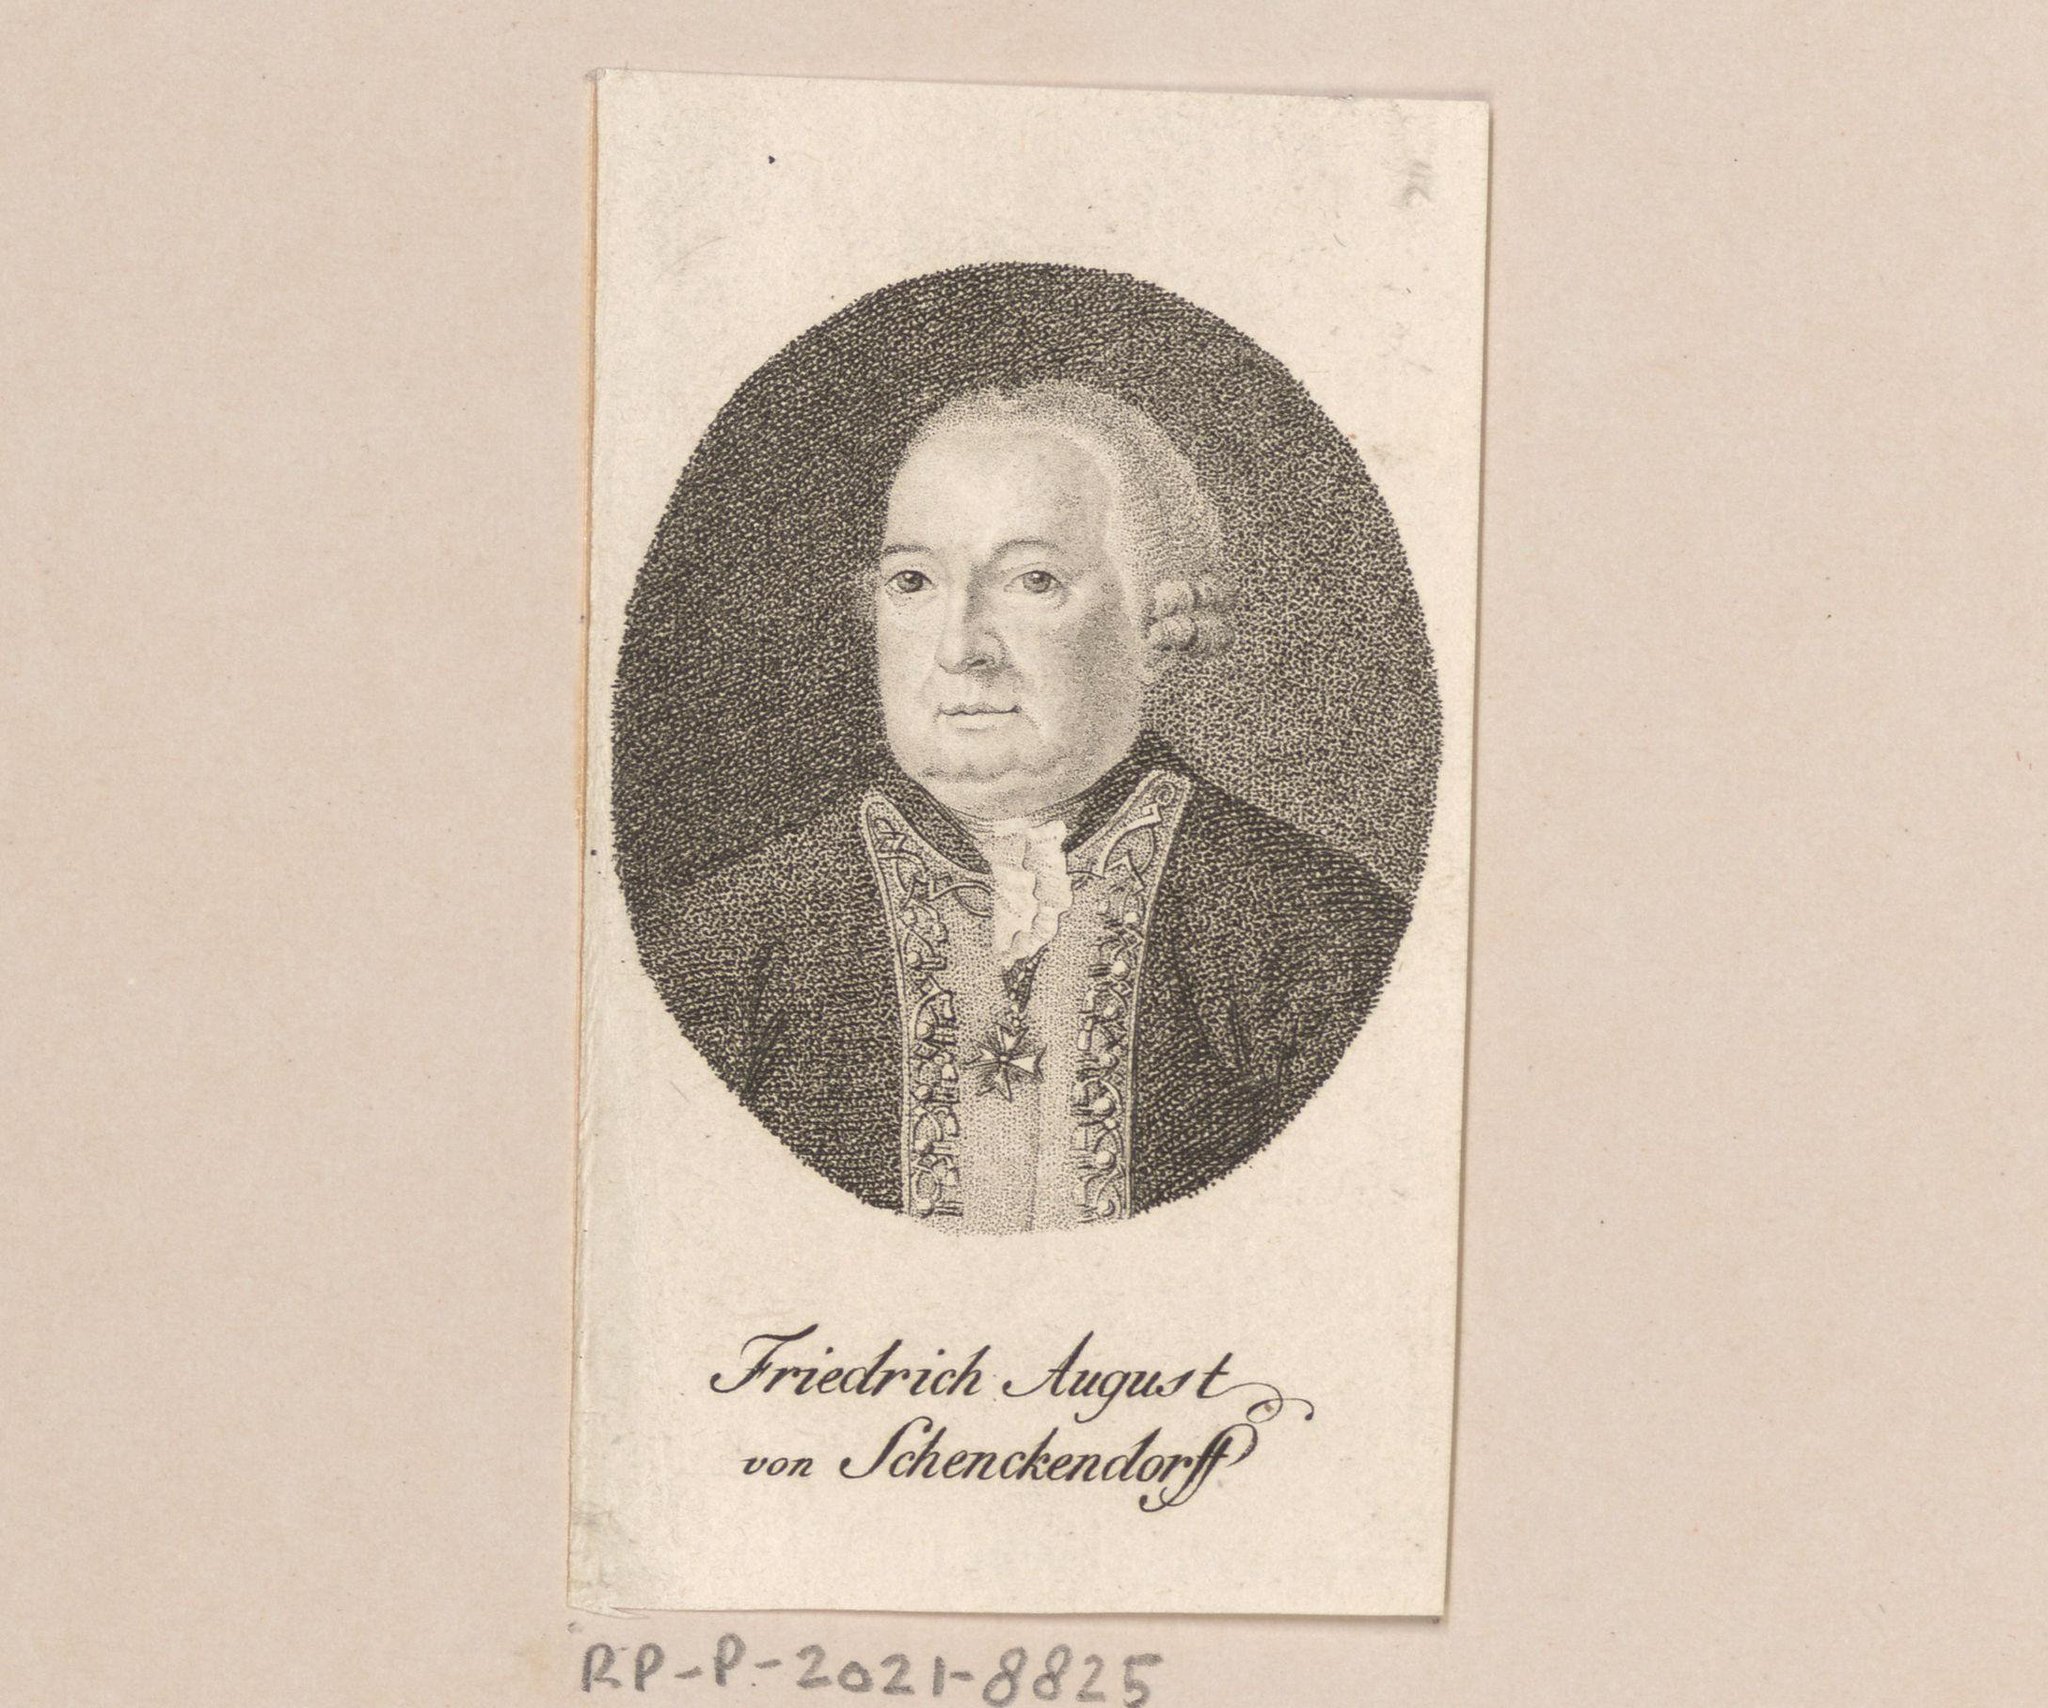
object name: print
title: Portret van Friedrich August von Schenckendorff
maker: Anonymous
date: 1750-1849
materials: paper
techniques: etching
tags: knighthood order, commander-in-chief, general, marshal, historical persons